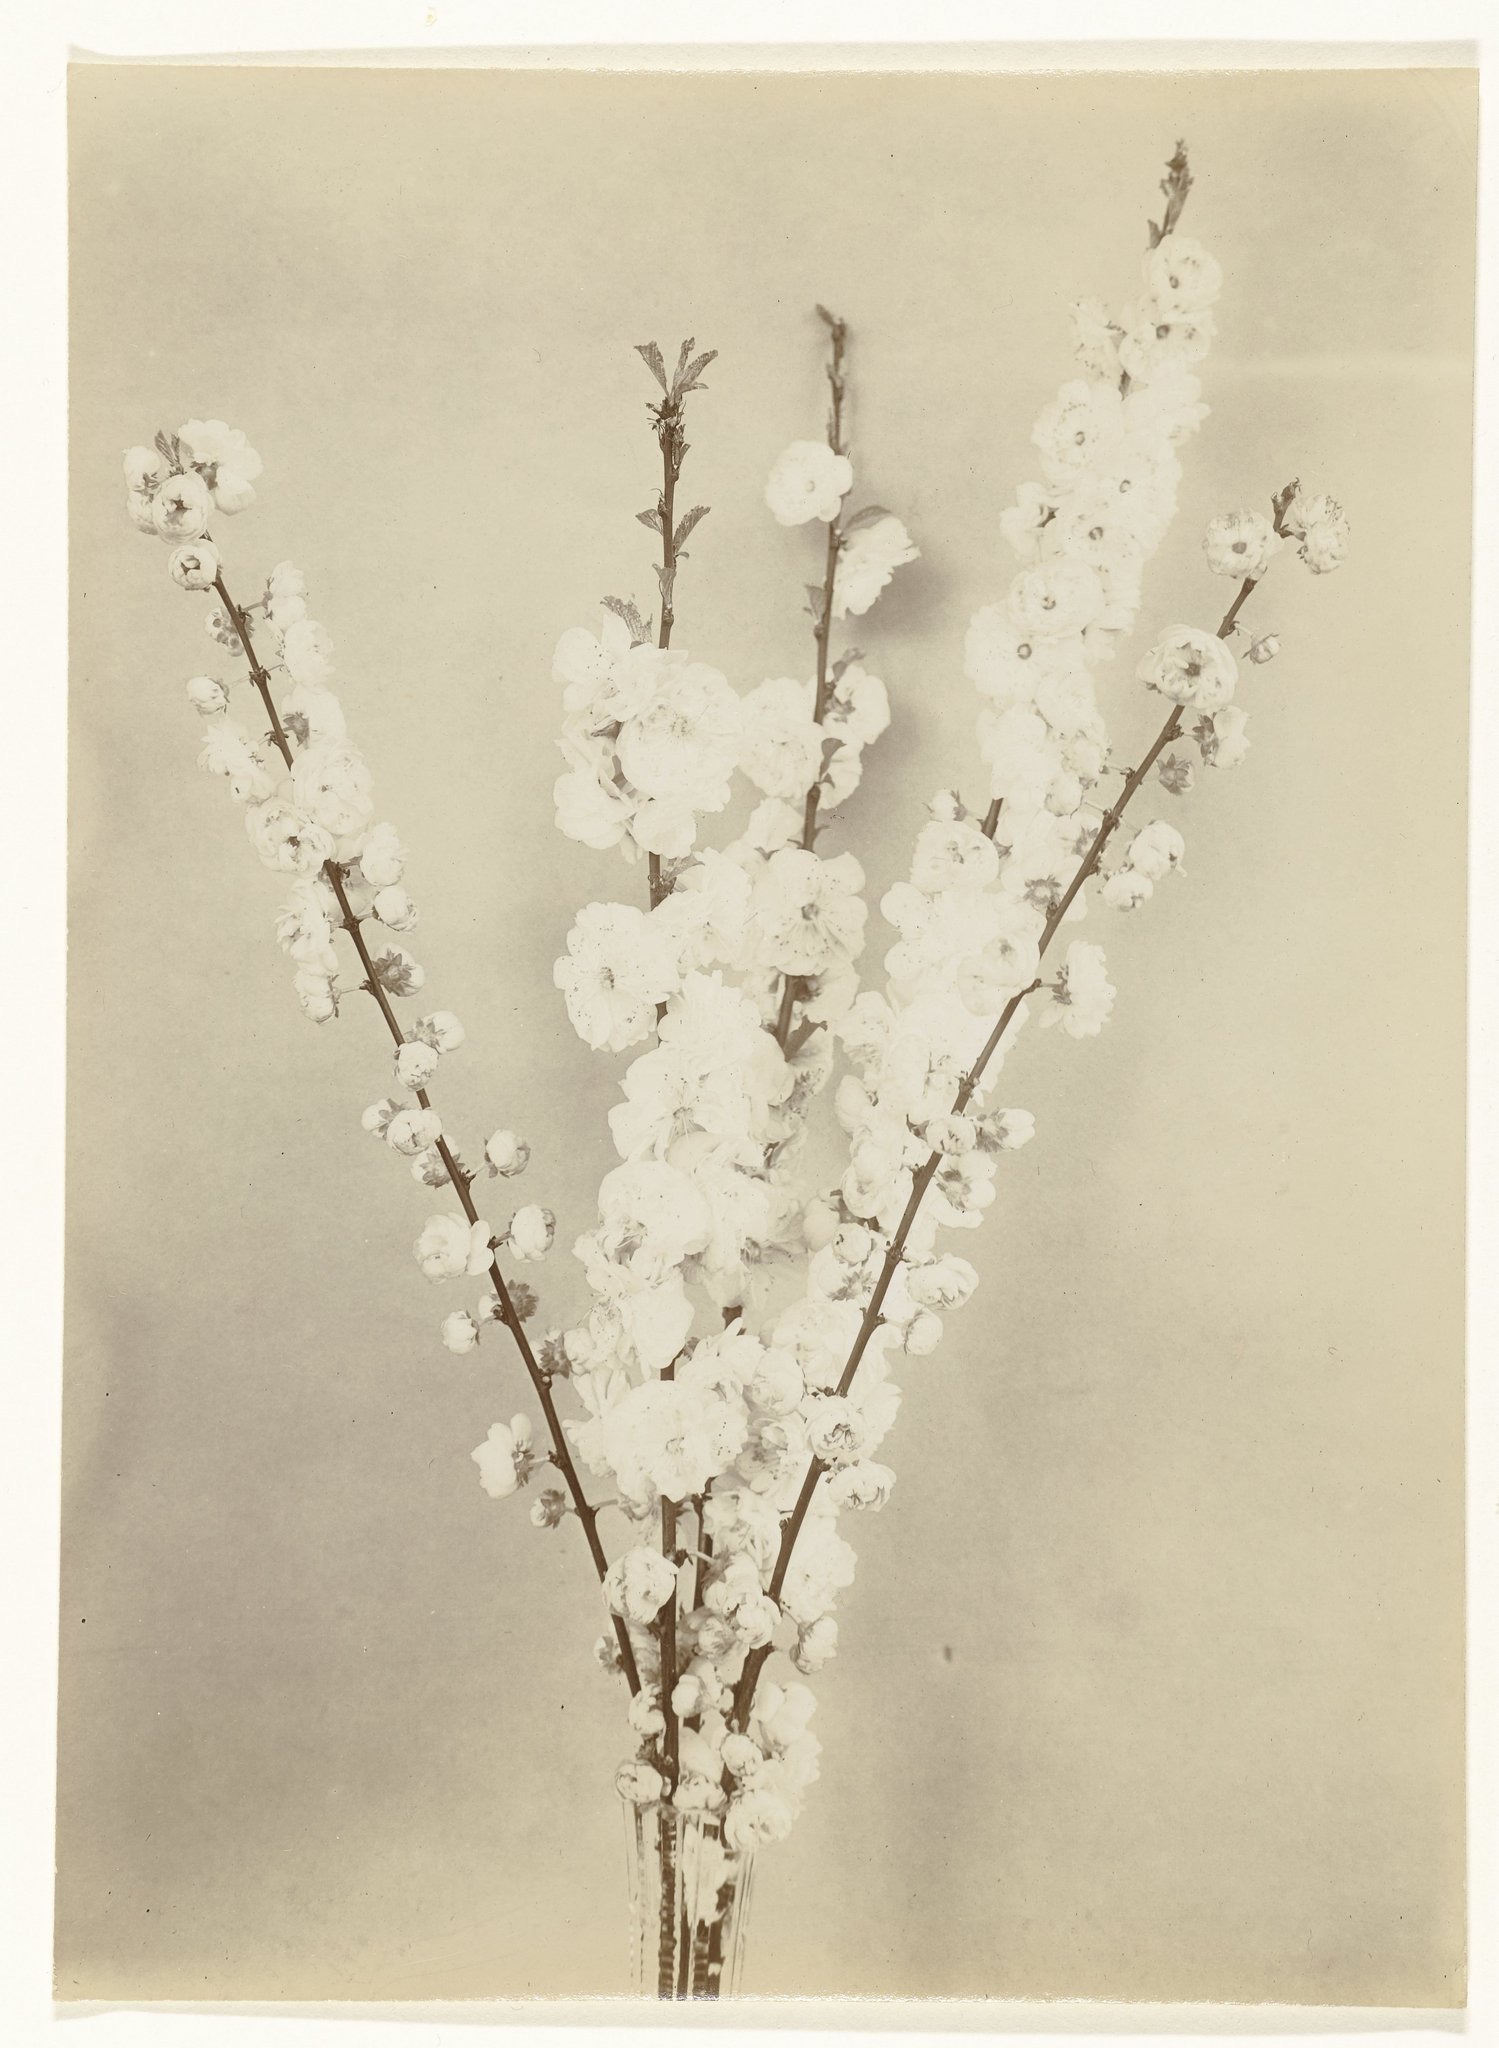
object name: photograph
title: Takken met bloesem van een amandelboom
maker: richard tepe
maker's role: fotograaf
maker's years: 1864-1952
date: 1900-1930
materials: photographic support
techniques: gelatin silver print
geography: apeldoorn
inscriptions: annotation: ‘Prunus triloba / bloeiende geforceerde takjes / in vaas’, signature: ‘foto / R Tepe’